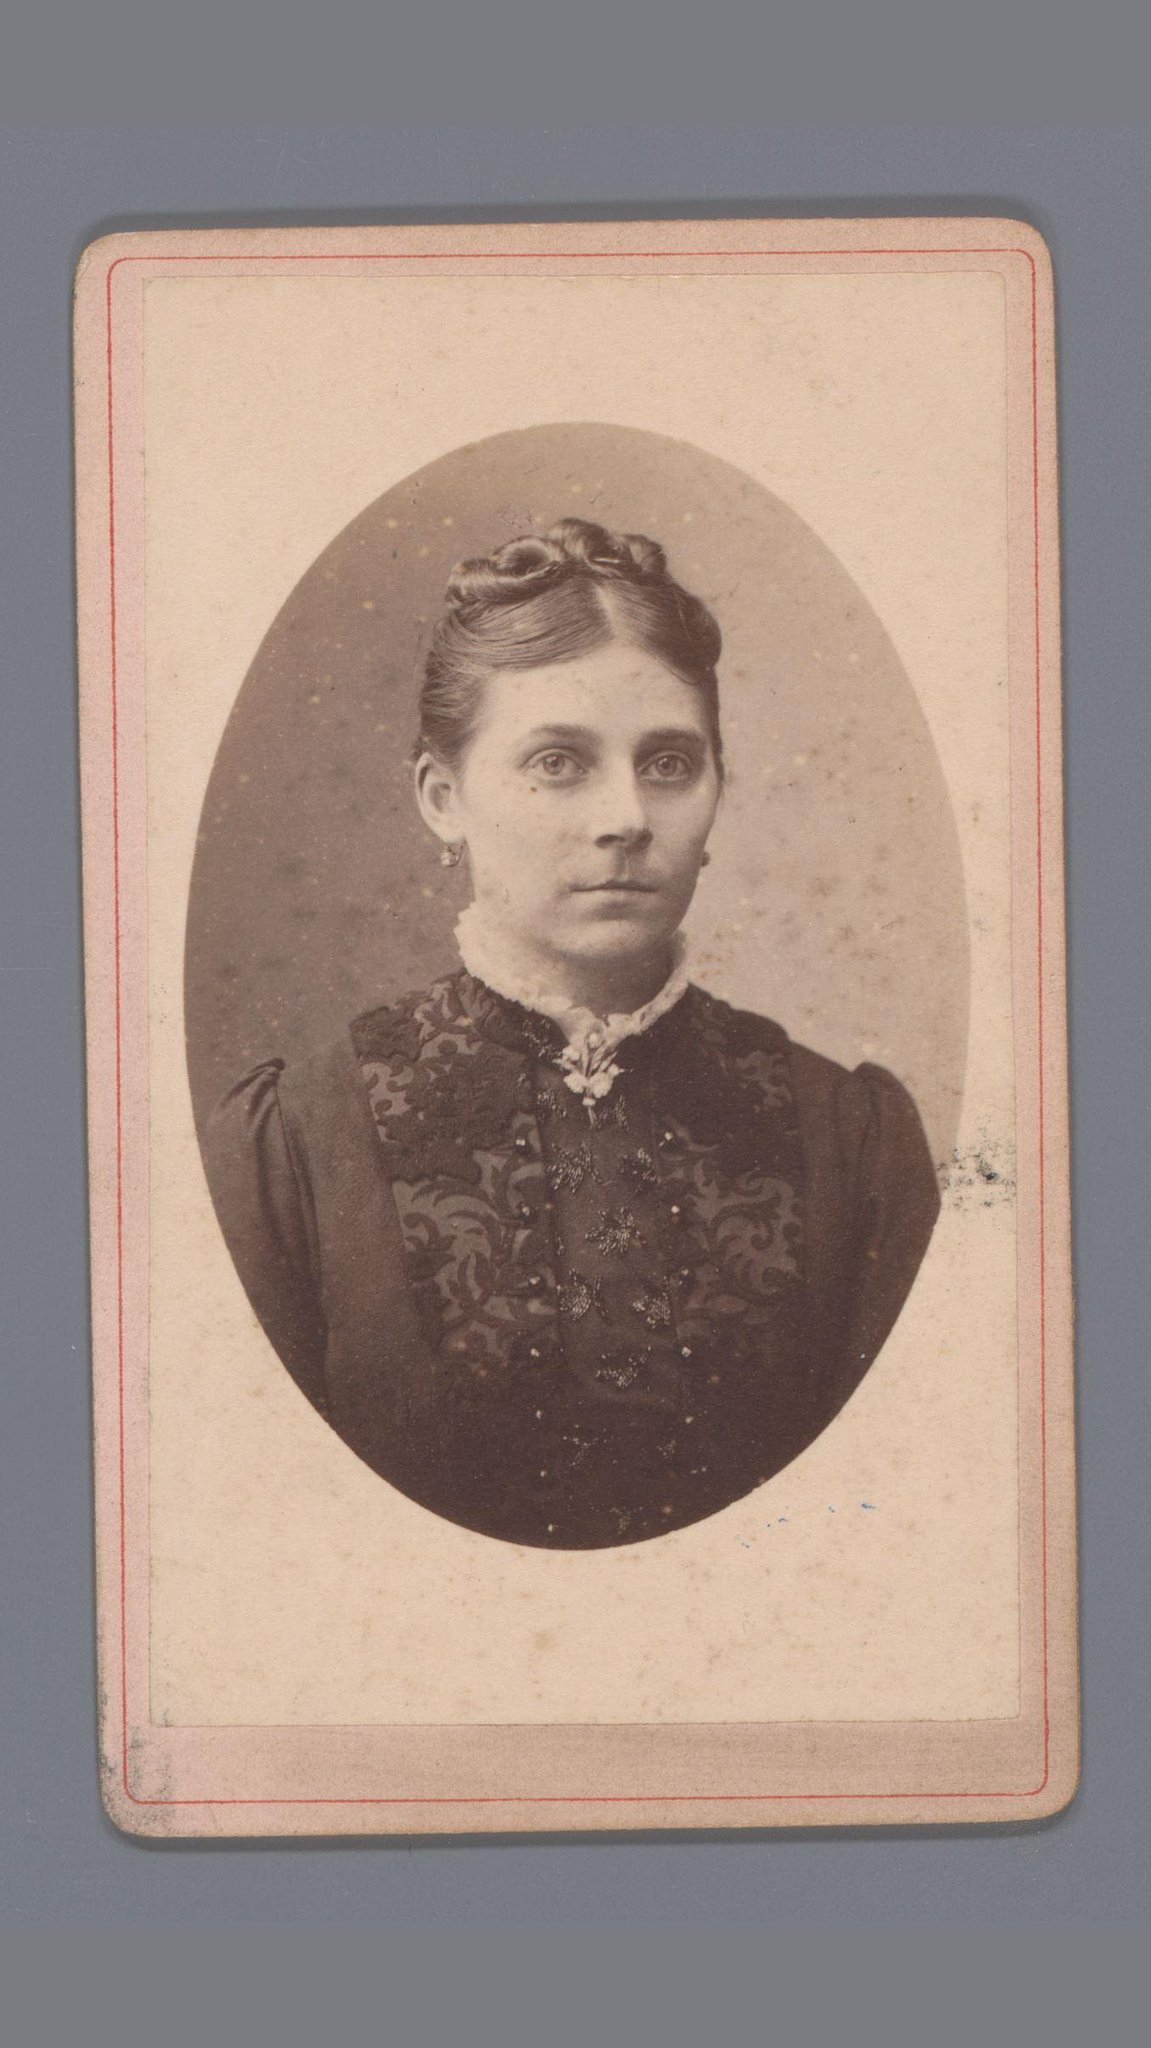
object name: carte de visite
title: Portret van een onbekende vrouw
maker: friedrich julius von kolkow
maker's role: fotograaf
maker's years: 1839-1914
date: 1884-1896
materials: cardboard, paper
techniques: albumen print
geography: groningen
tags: historical persons - bb - woman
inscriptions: inscription: ‘GOUDEN MEDALJE VOOR KUNST EN WETENSCHAP v Z. M. de KONING v WÜRTTEMBERG/ aan het lint der Frederiksorde/ PHILADELPHIA 1876. WIEN 1873./ FR. JUL. VON KOLKOW/ KONINKLIJK NEDERLANDSCH HOF-PHOTOGRAPH/ Silberne Voigtländer Medaille Kunst u Wissenschaft Oldenburg/ en tien zilveren Medaljes op andere Tentoonstellingen./ GRONINGEN/ Groote Markt bij de/ Martinitoorn./ Specialiteit in Vergrootingen.’